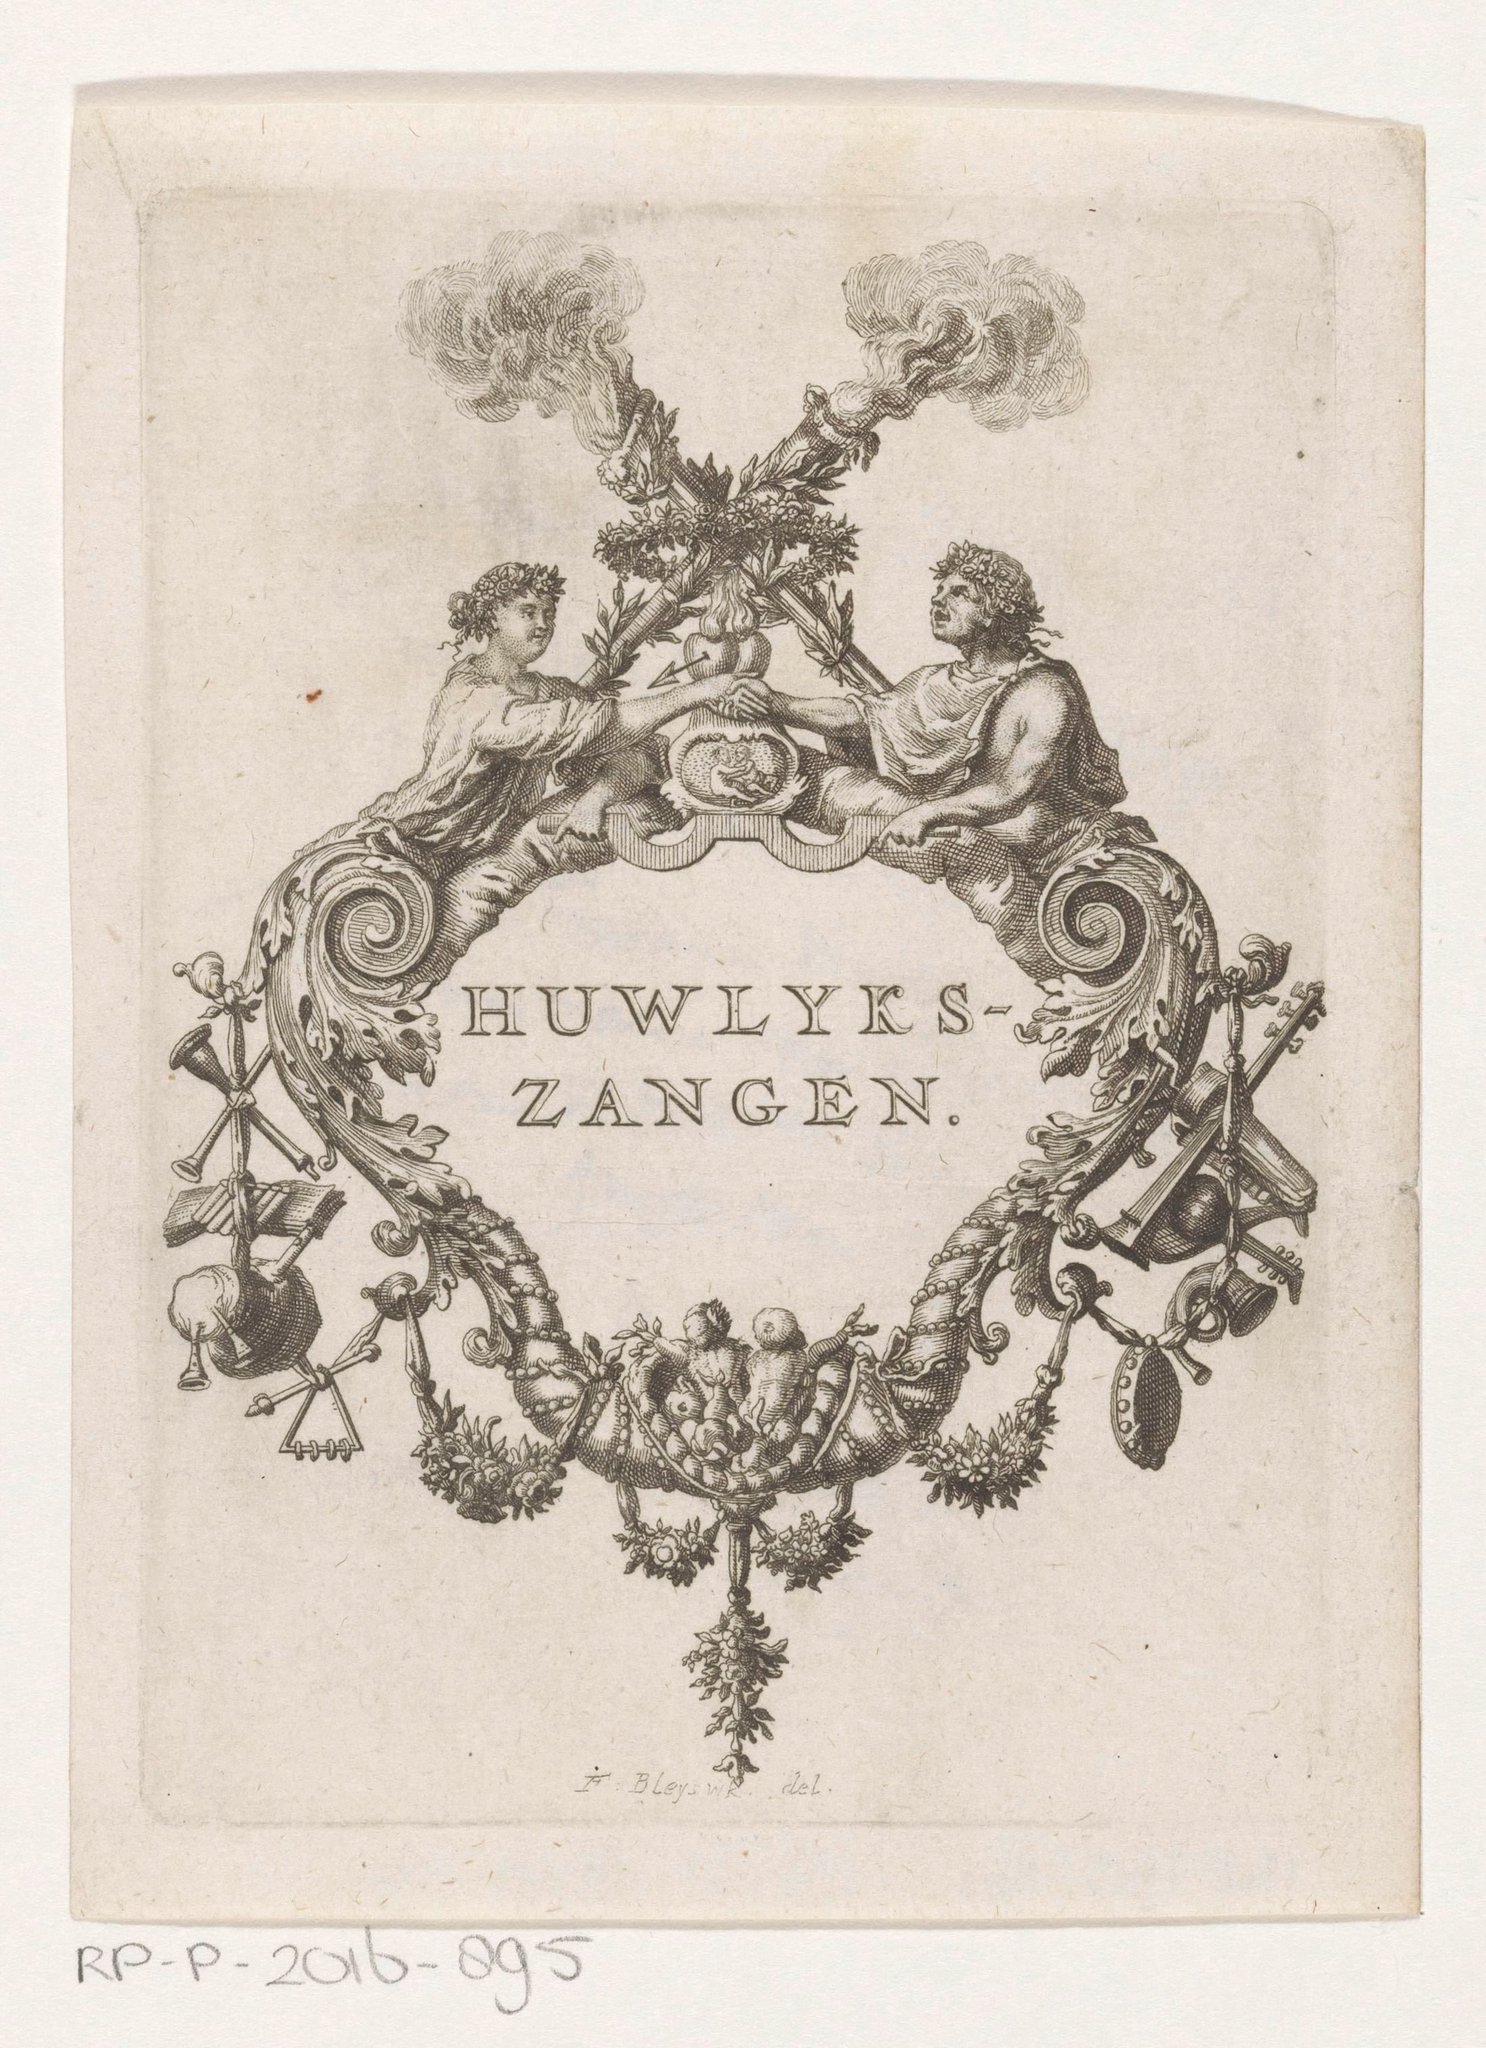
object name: print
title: Huwlyks-zangen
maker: françois van bleyswijck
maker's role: draughtsman, print maker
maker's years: 1671-1746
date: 1718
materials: paper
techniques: engraving, etching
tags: marriage, married couple, 'matrimonium', profane heart symbolism ~ love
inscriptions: collector's mark: Lugt 2760, collector's mark: Lugt 2228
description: Vignet met omlijsting waarin huwelijkspaar en symbolen van liefde zijn opgenomen. De bruid en bruidegom reiken elkaar de hand en hun liefde wordt gesymboliseerd met een brandend hart en brandende fakkels. Twee hoornen des overvloeds sluiten de lijst aan de onderkant en de krullende ornamenten links en rechts die de hoornen en figuren samenvoegen zijn versierd met linten waaraan muziekinstrumenten en guirlandes hangen.